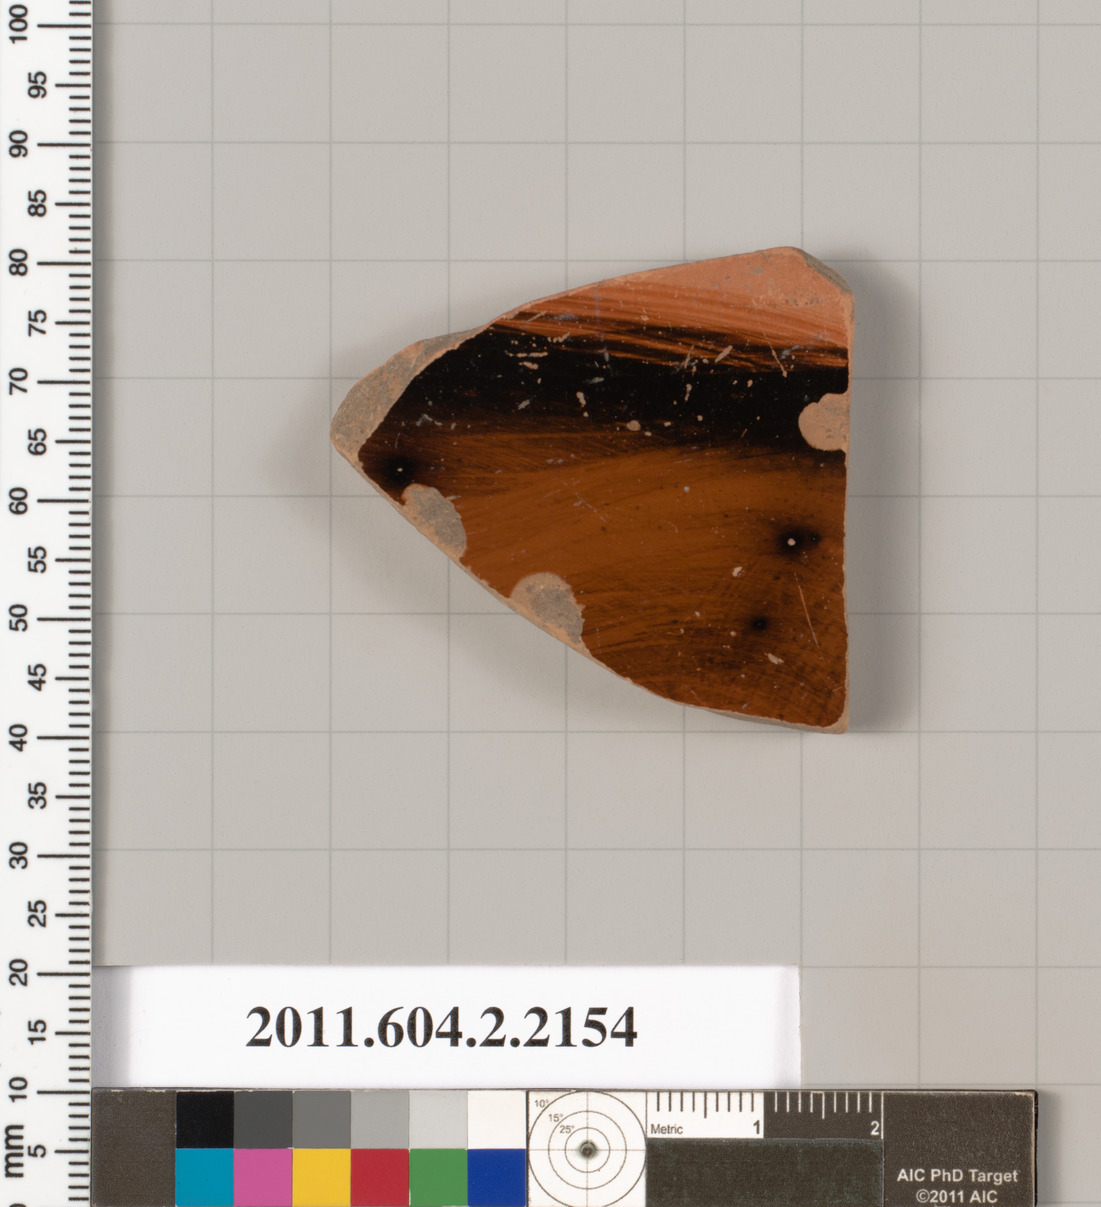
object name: pot fragment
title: Terracotta fragment of a pot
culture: greek, attic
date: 600-401 BCE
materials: terracotta